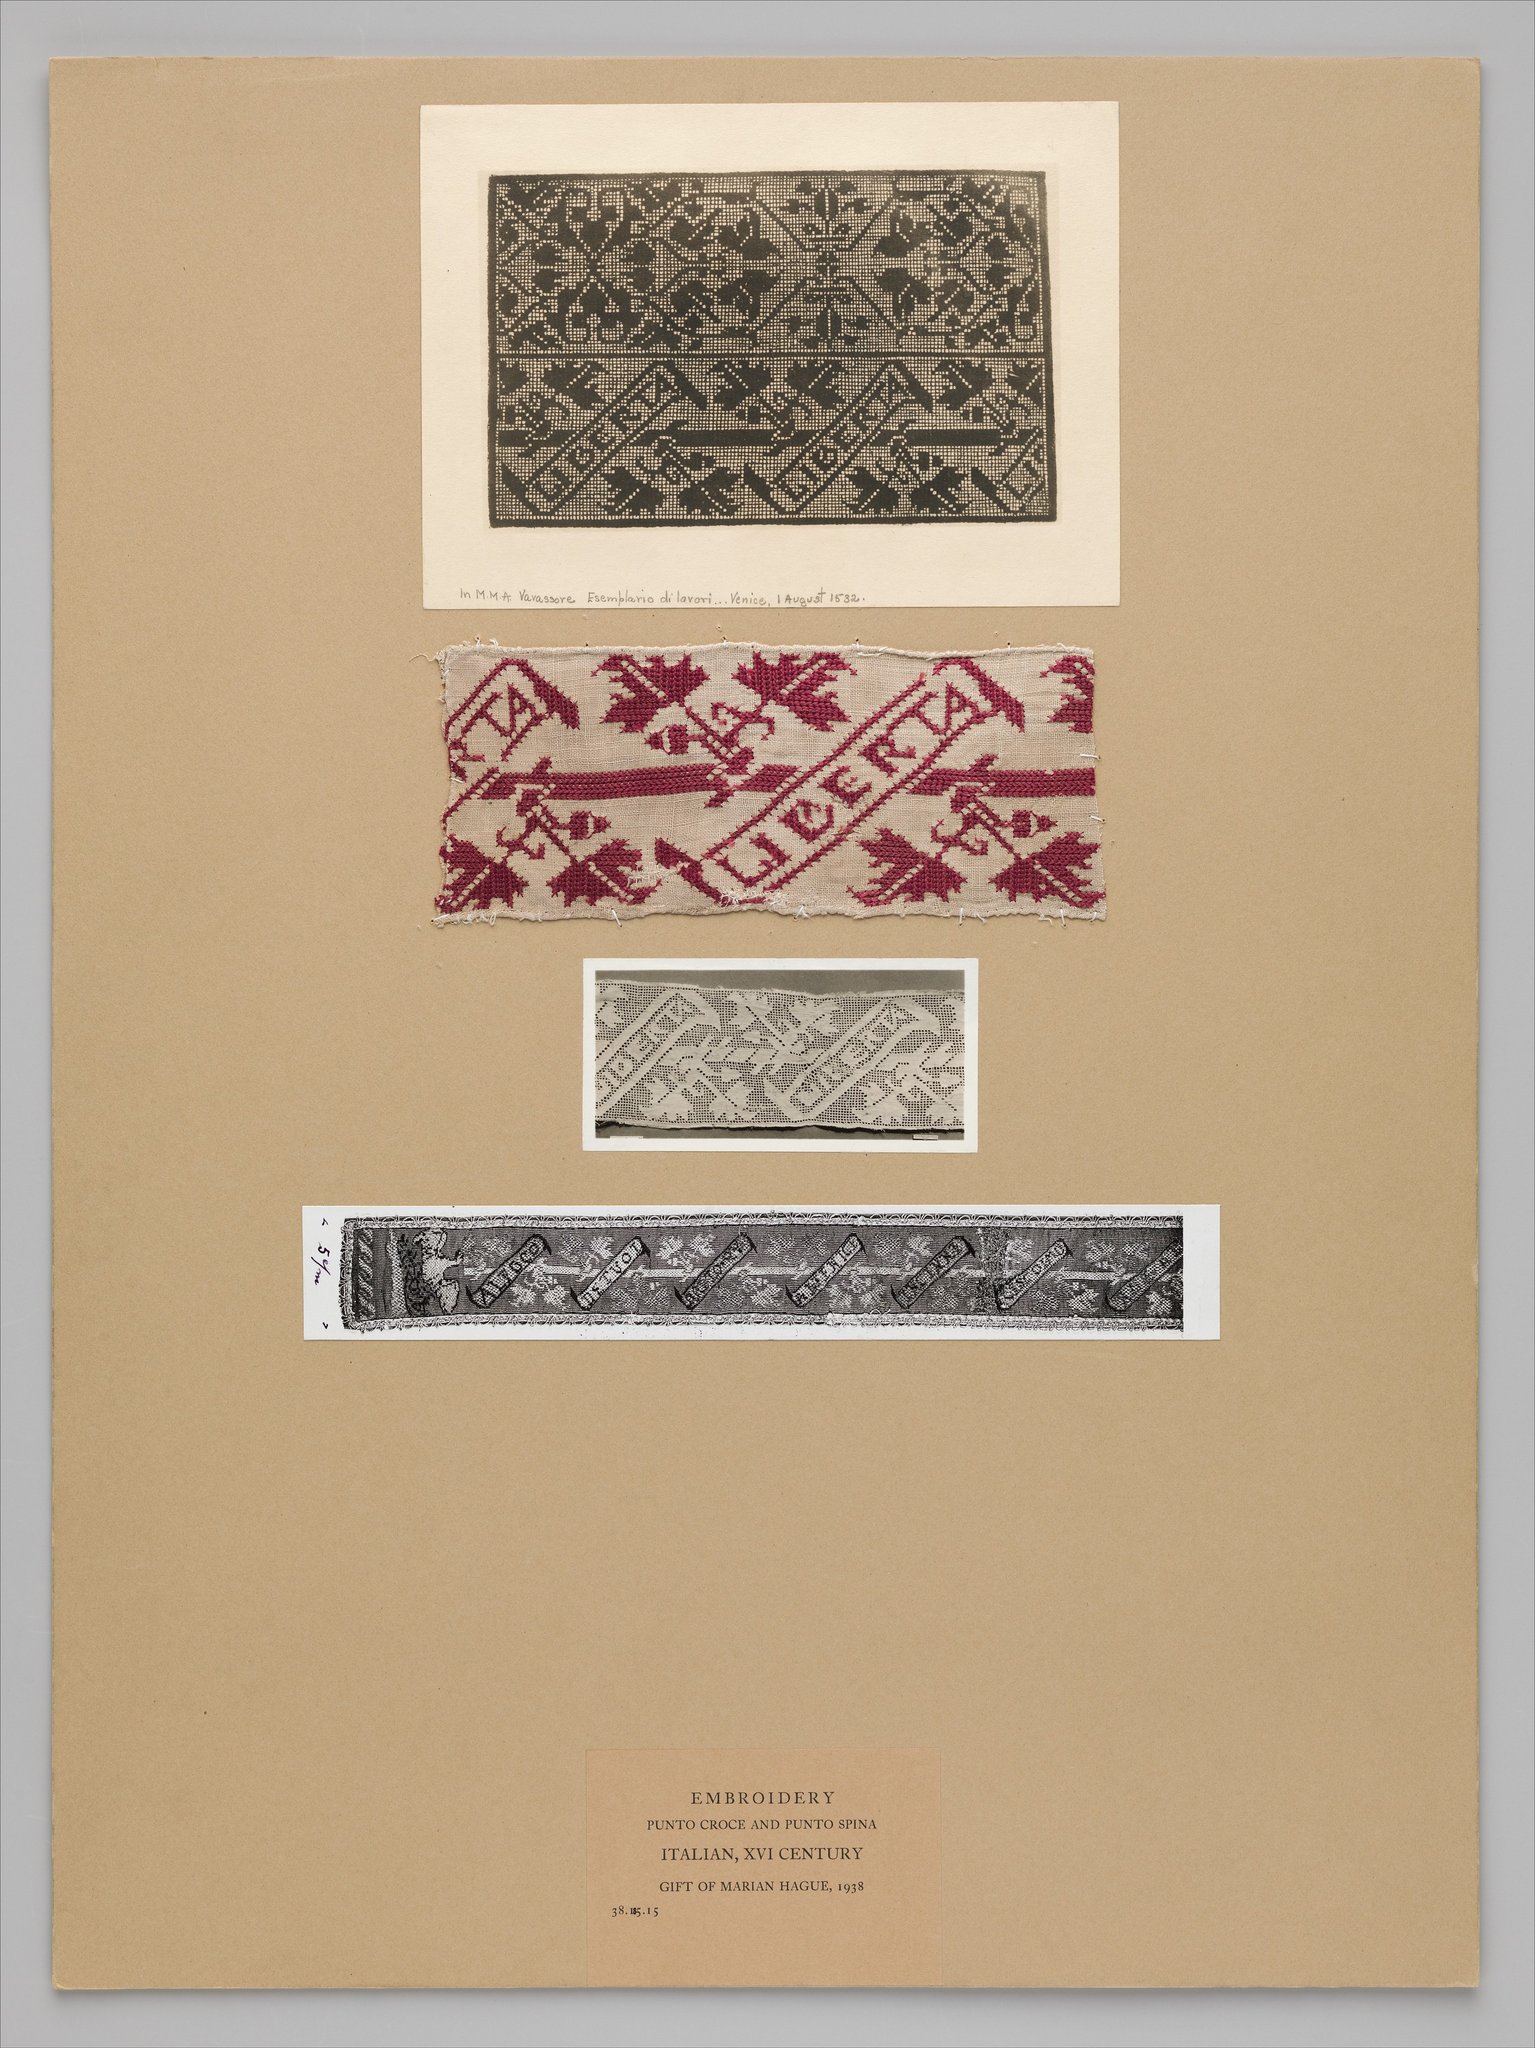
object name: band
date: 1501-1600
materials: linen, silk